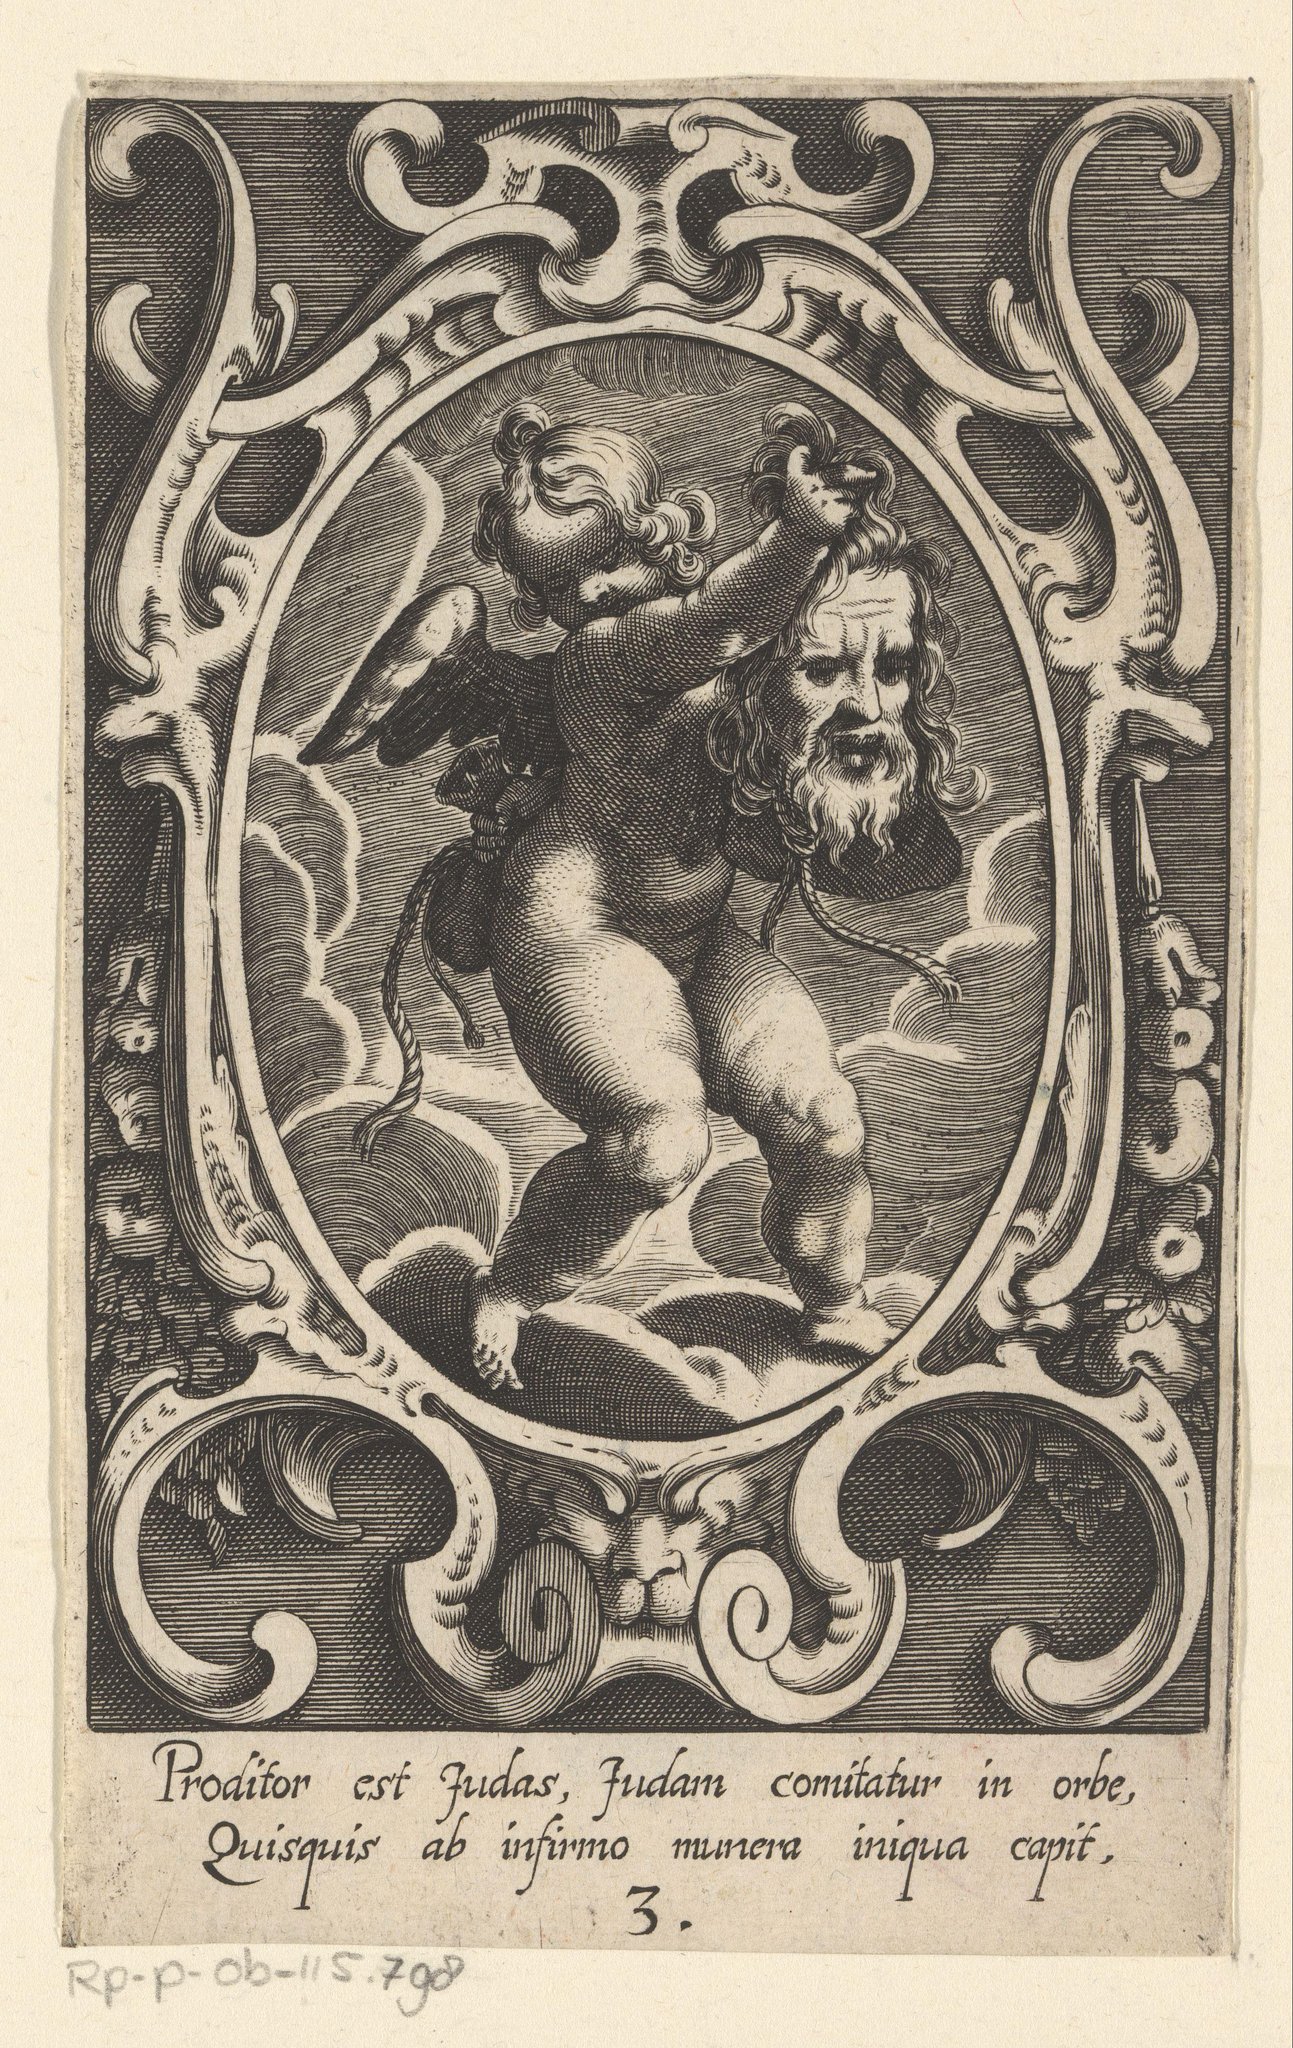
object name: print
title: De passiewerktuigen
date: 1620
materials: paper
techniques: engraving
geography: augsburg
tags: 'arma christi', head of judas ~ instruments of the passion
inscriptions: collector's mark: Lugt 240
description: Serie bevattende een titelprent en elf prenten van de passiewerktuigen. De prenten zijn genummerd van één tot en met twaalf. Nummer tien is niet aanwezig in deze serie, evenals in de series genoemd in de referentielitertuur.